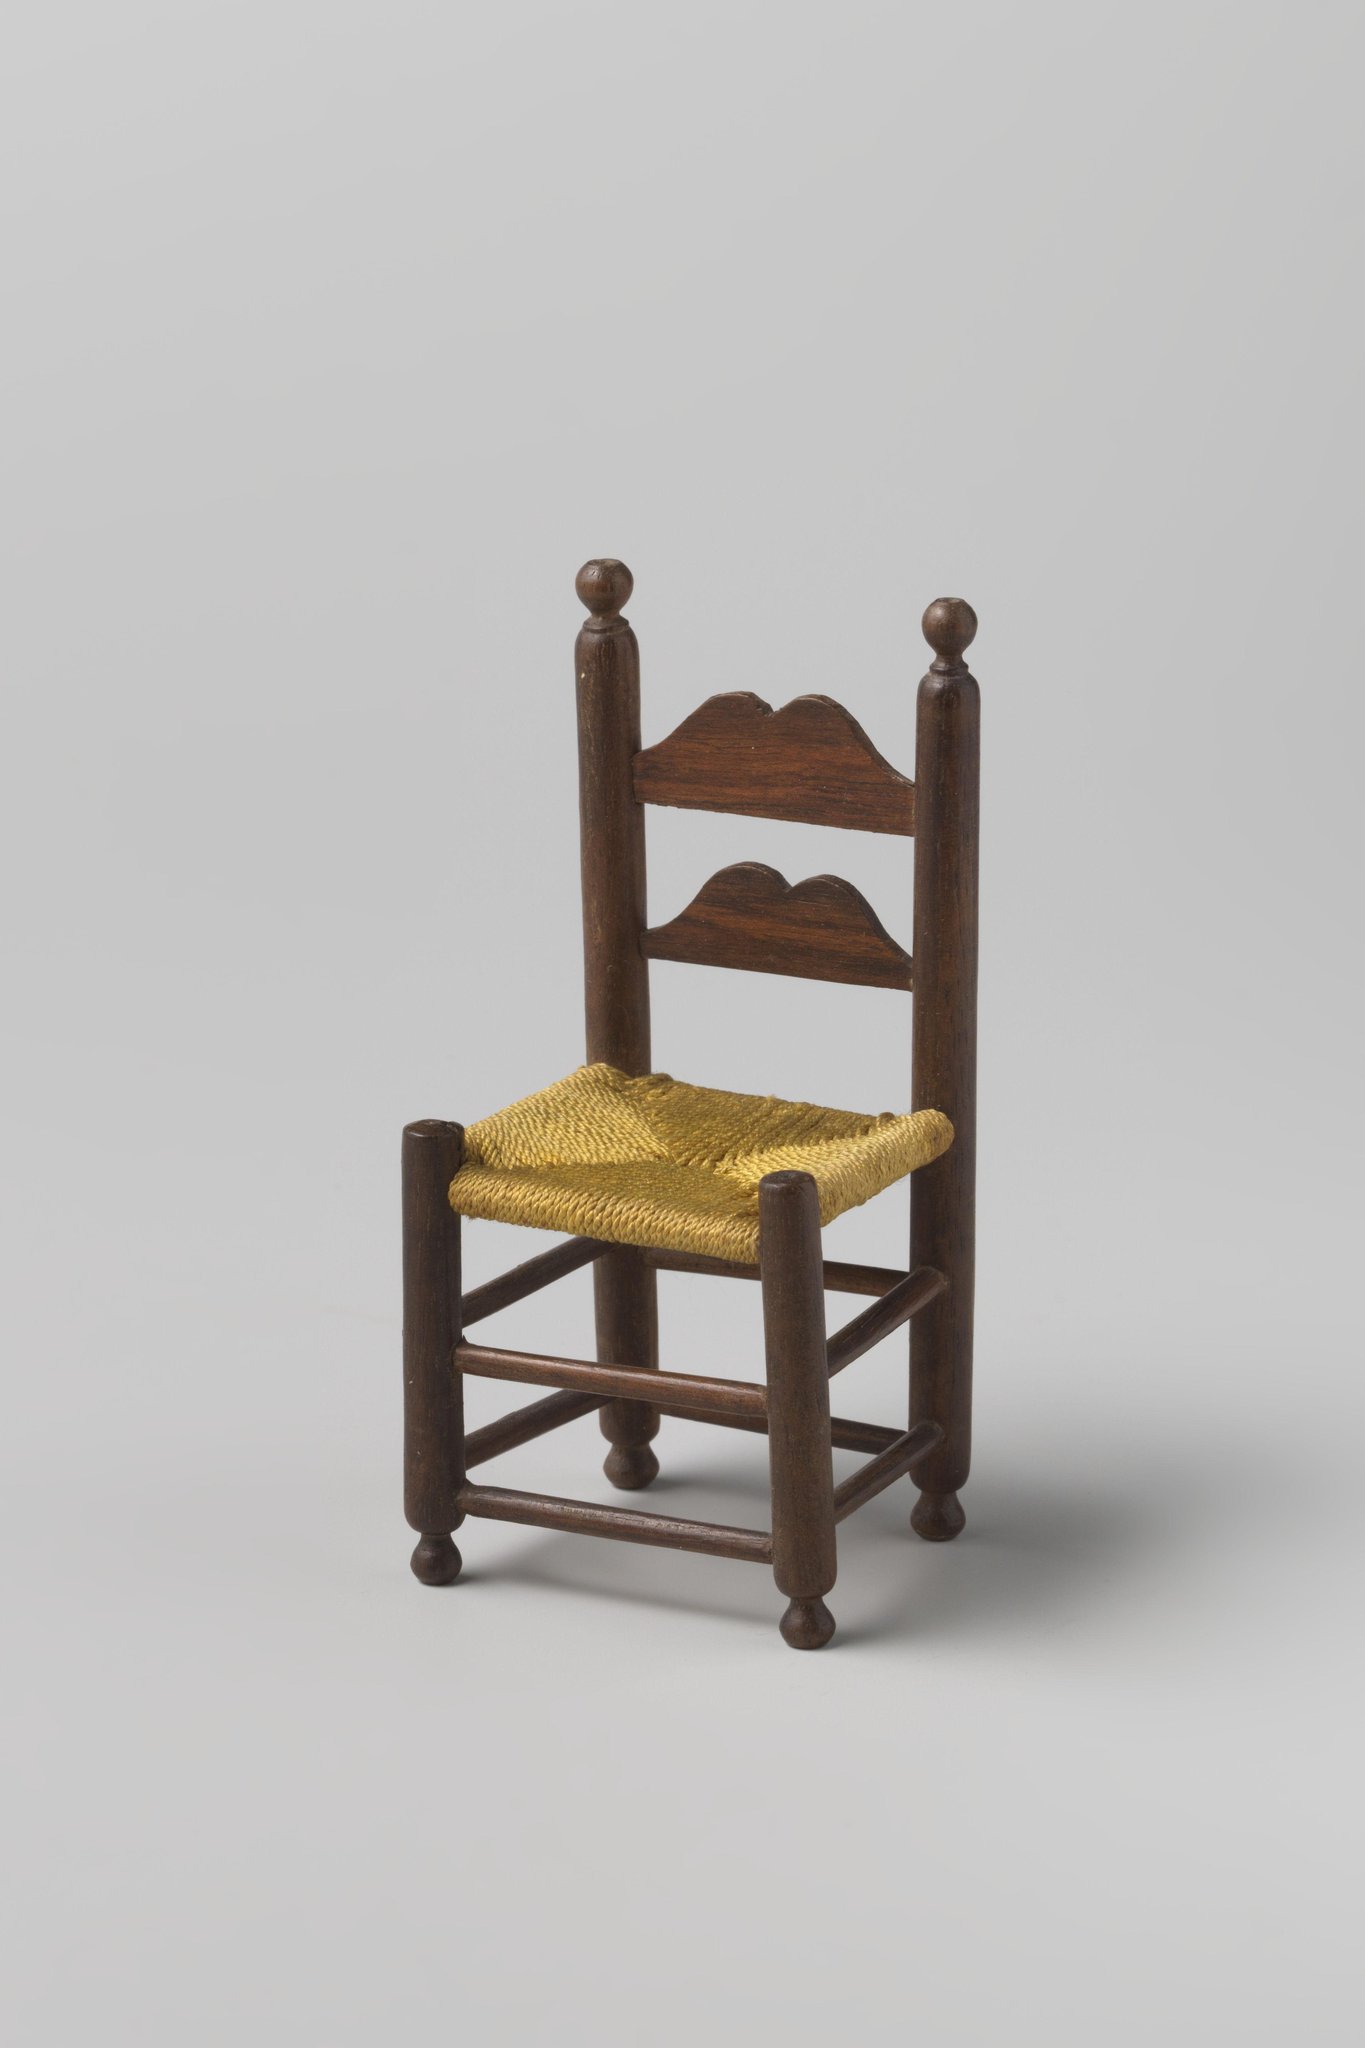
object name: miniature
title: Stoel van notenhout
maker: Anonymous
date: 1676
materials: silk, wood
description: Stoel van notenhout met gladde gedraaide stijlen en dwarsregels. De poten en rugstijlen eindigend in bollen. De rugleuning met twee platte dwarssporten in dubbele boog gezaagd. De zitting imitatie mattenbies, gevlochten van geel, getwist zijden koord.